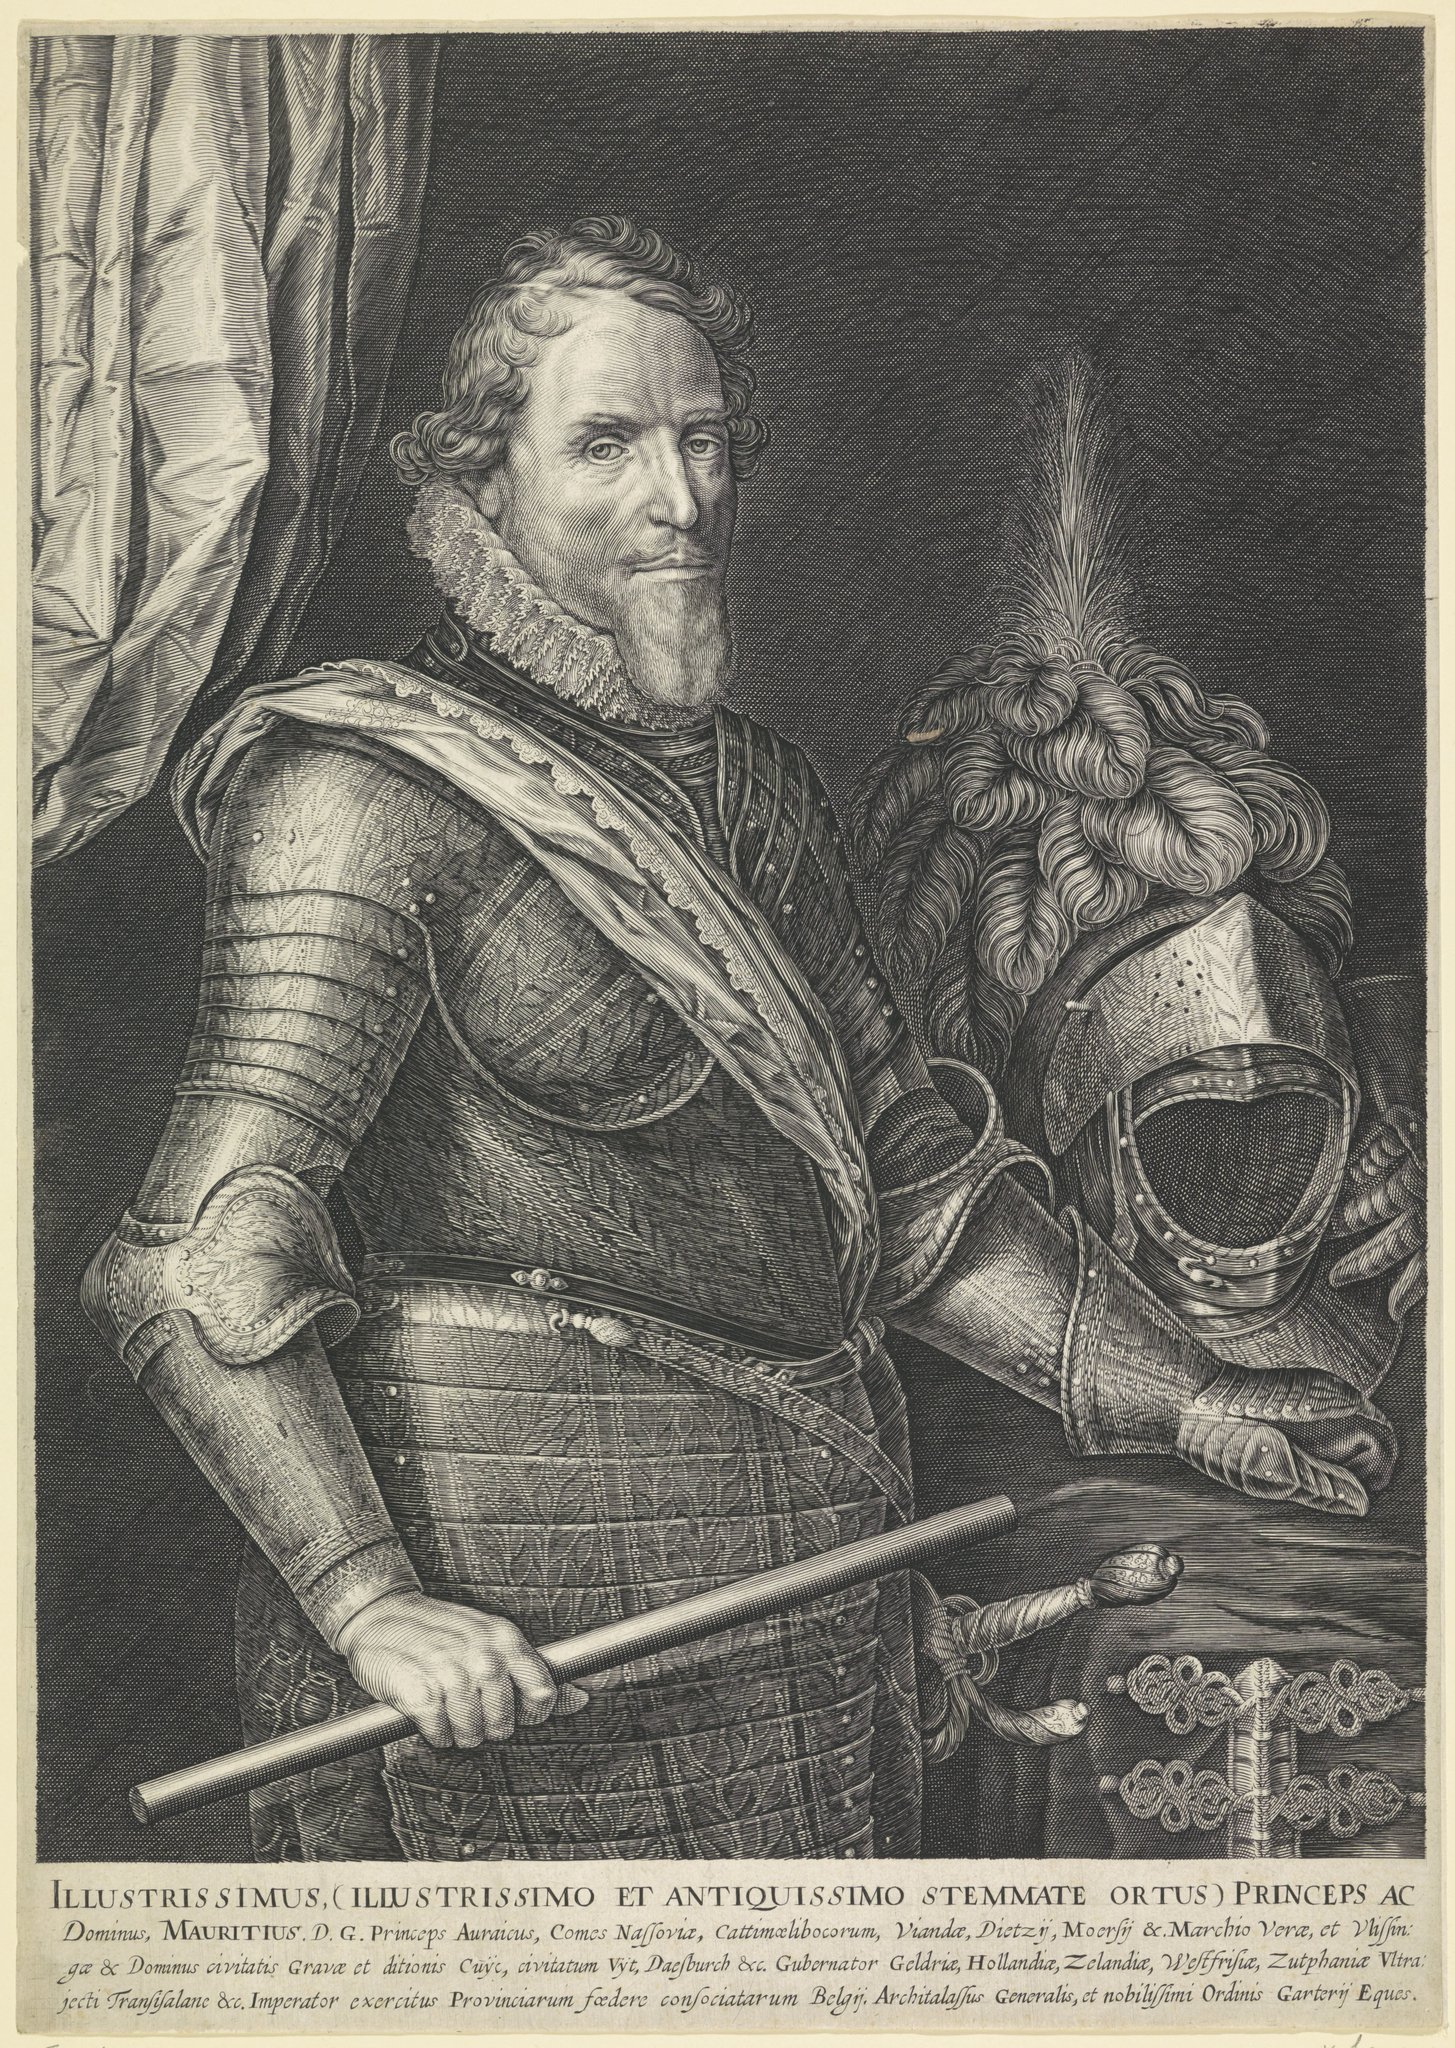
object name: print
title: Portret van Maurits, prins van Oranje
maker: Anonymous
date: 1608-1699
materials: paper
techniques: engraving, etching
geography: low countries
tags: the hague, maurice (prince of orange)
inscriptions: collector's mark: Lugt 963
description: Portret van Maurits. Hij staat naast een tafel met daarop de helm van zijn harnas. Hij houdt een commandostaf in de hand. In de ondermarge vier regels Latijnse tekst.